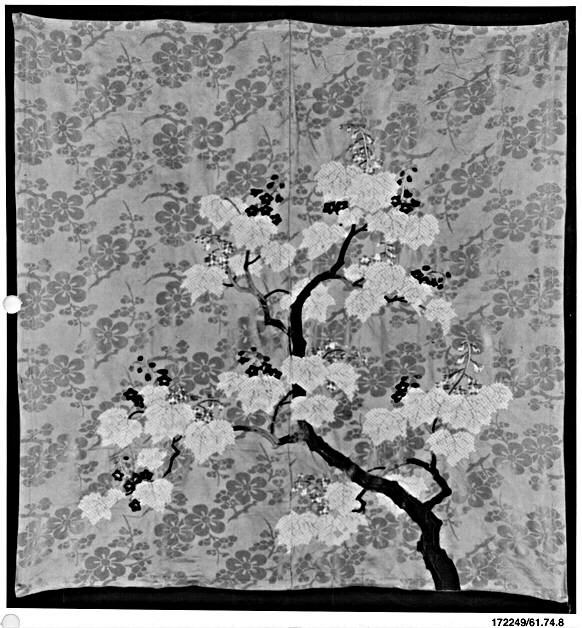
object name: piece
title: Piece, Gift Cover?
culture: japanese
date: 1834-1866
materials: metal thread, silk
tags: trees